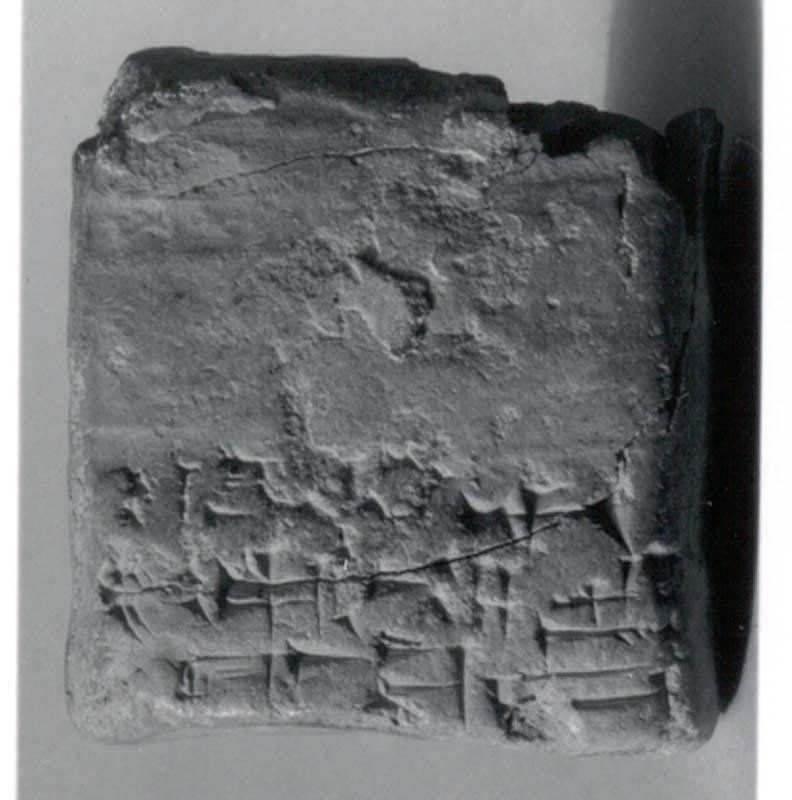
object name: cuneiform tablet case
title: Cuneiform tablet case impressed with cylinder seal, for cuneiform tablet 11.217.9a: receipt of a goat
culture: neo-sumerian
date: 2044 BCE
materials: clay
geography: mesopotamia